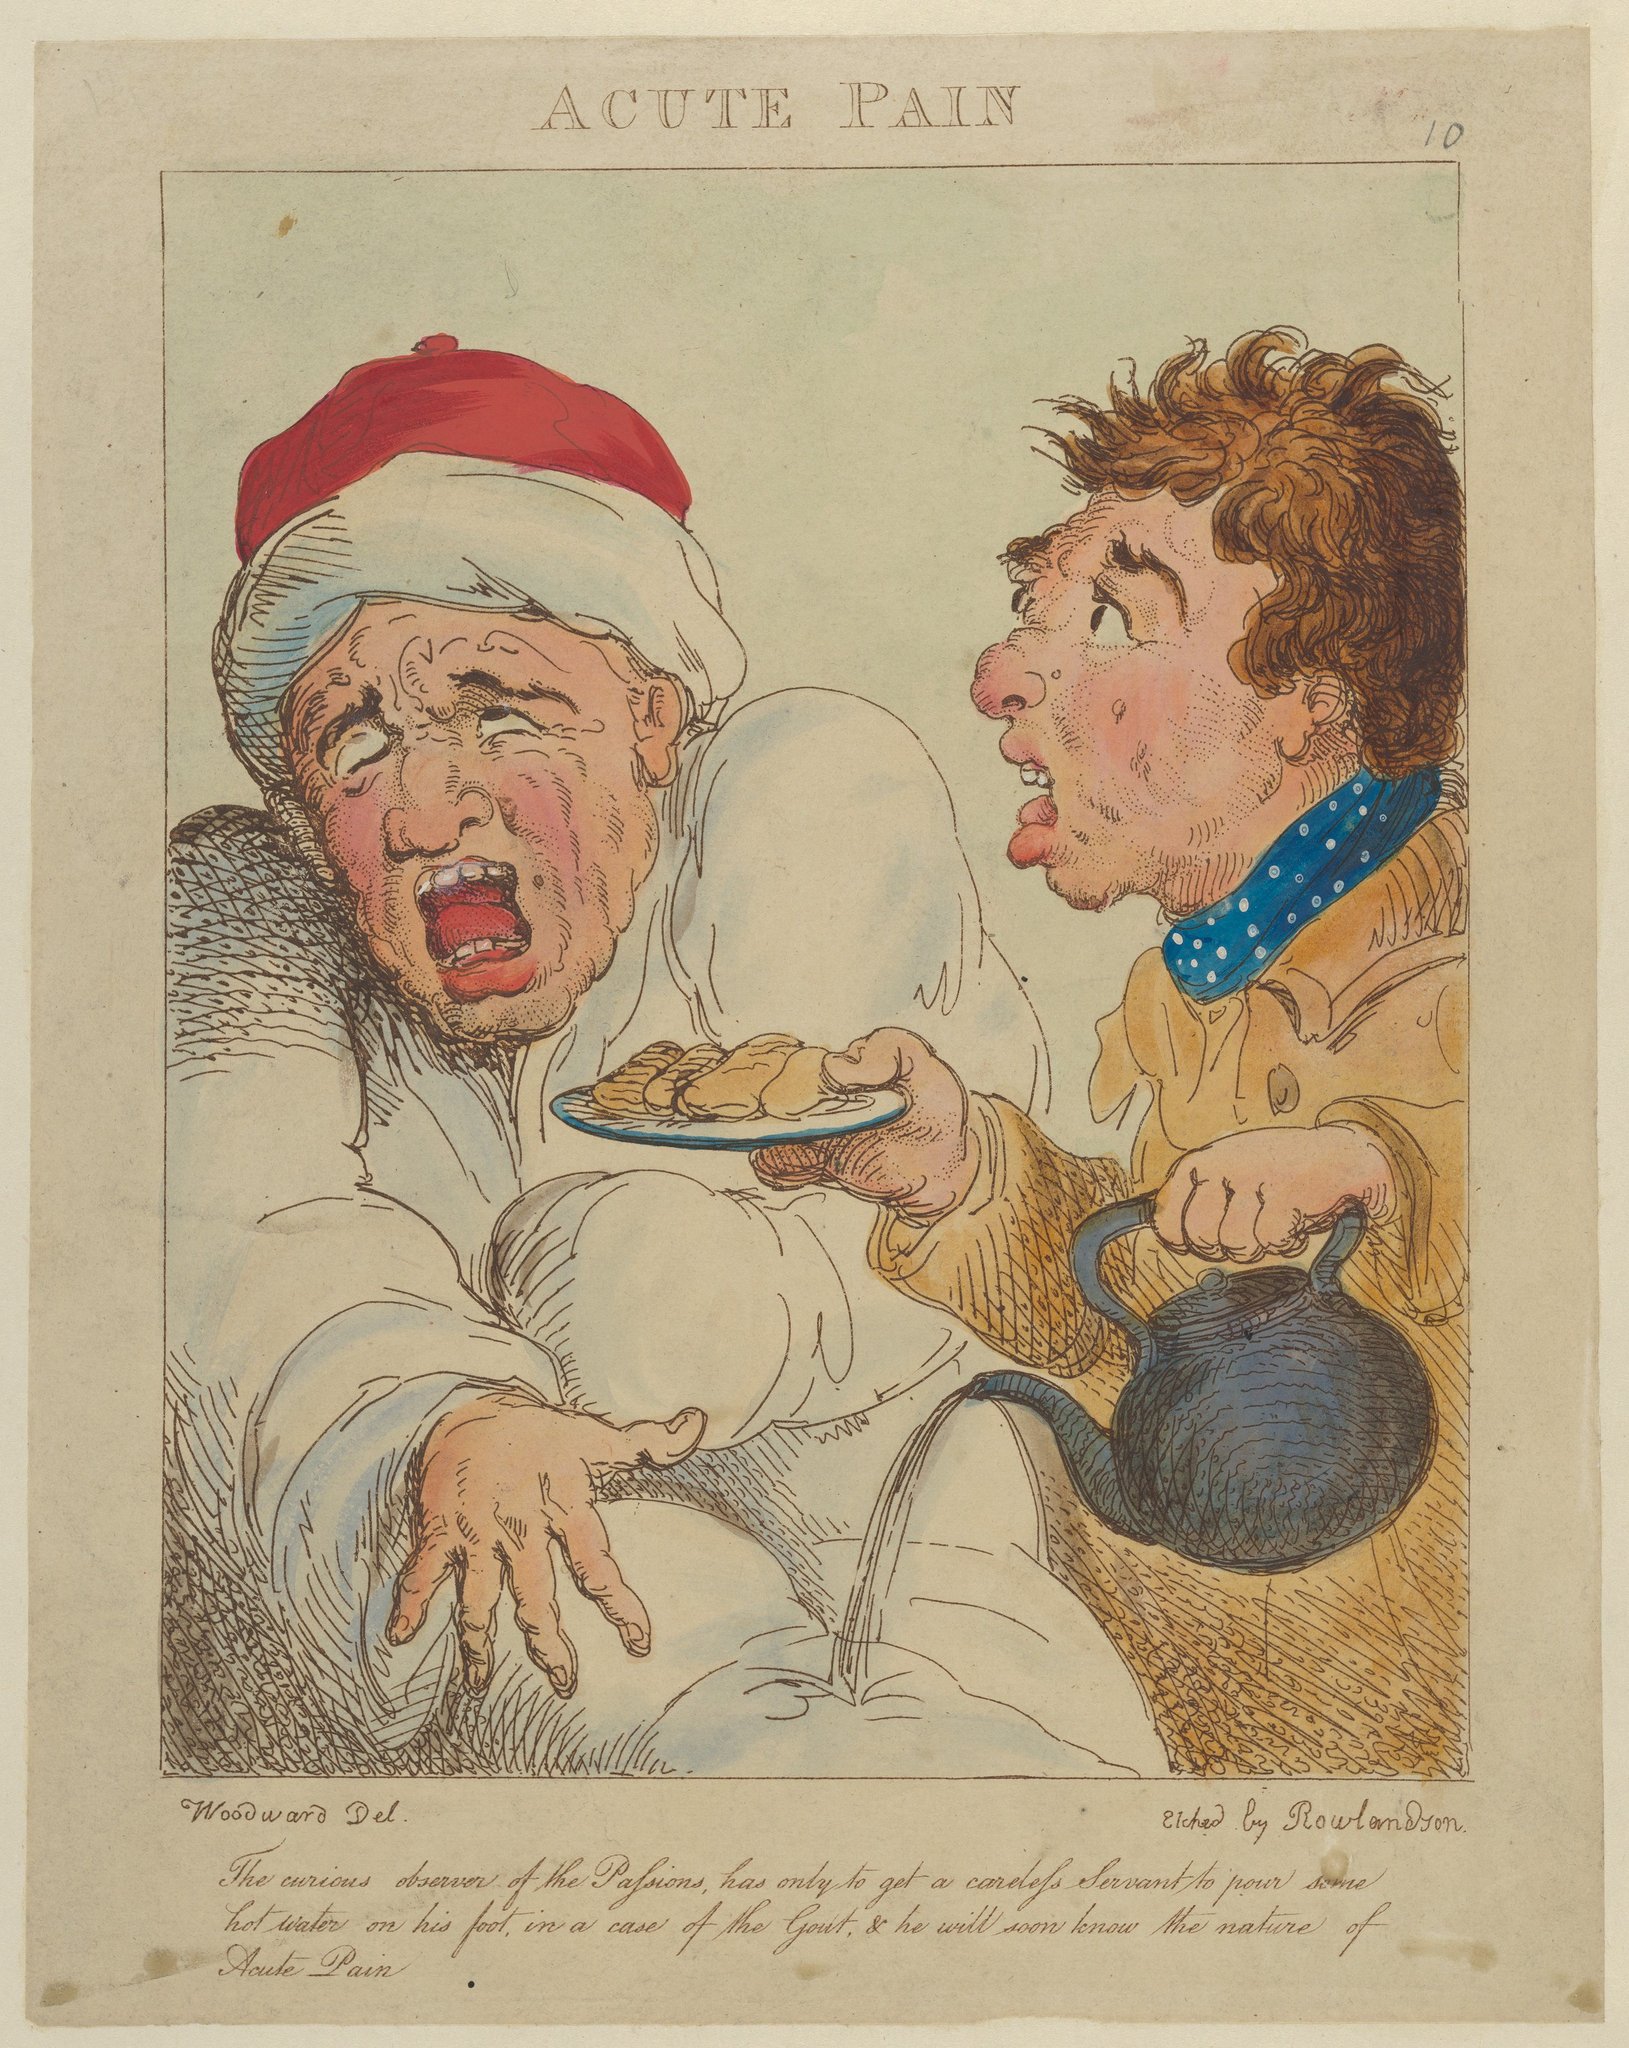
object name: print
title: Acute Pain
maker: thomas rowlandson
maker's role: artist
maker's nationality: british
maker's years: 1757-1827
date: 1800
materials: ink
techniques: etching, printing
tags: suffering,men